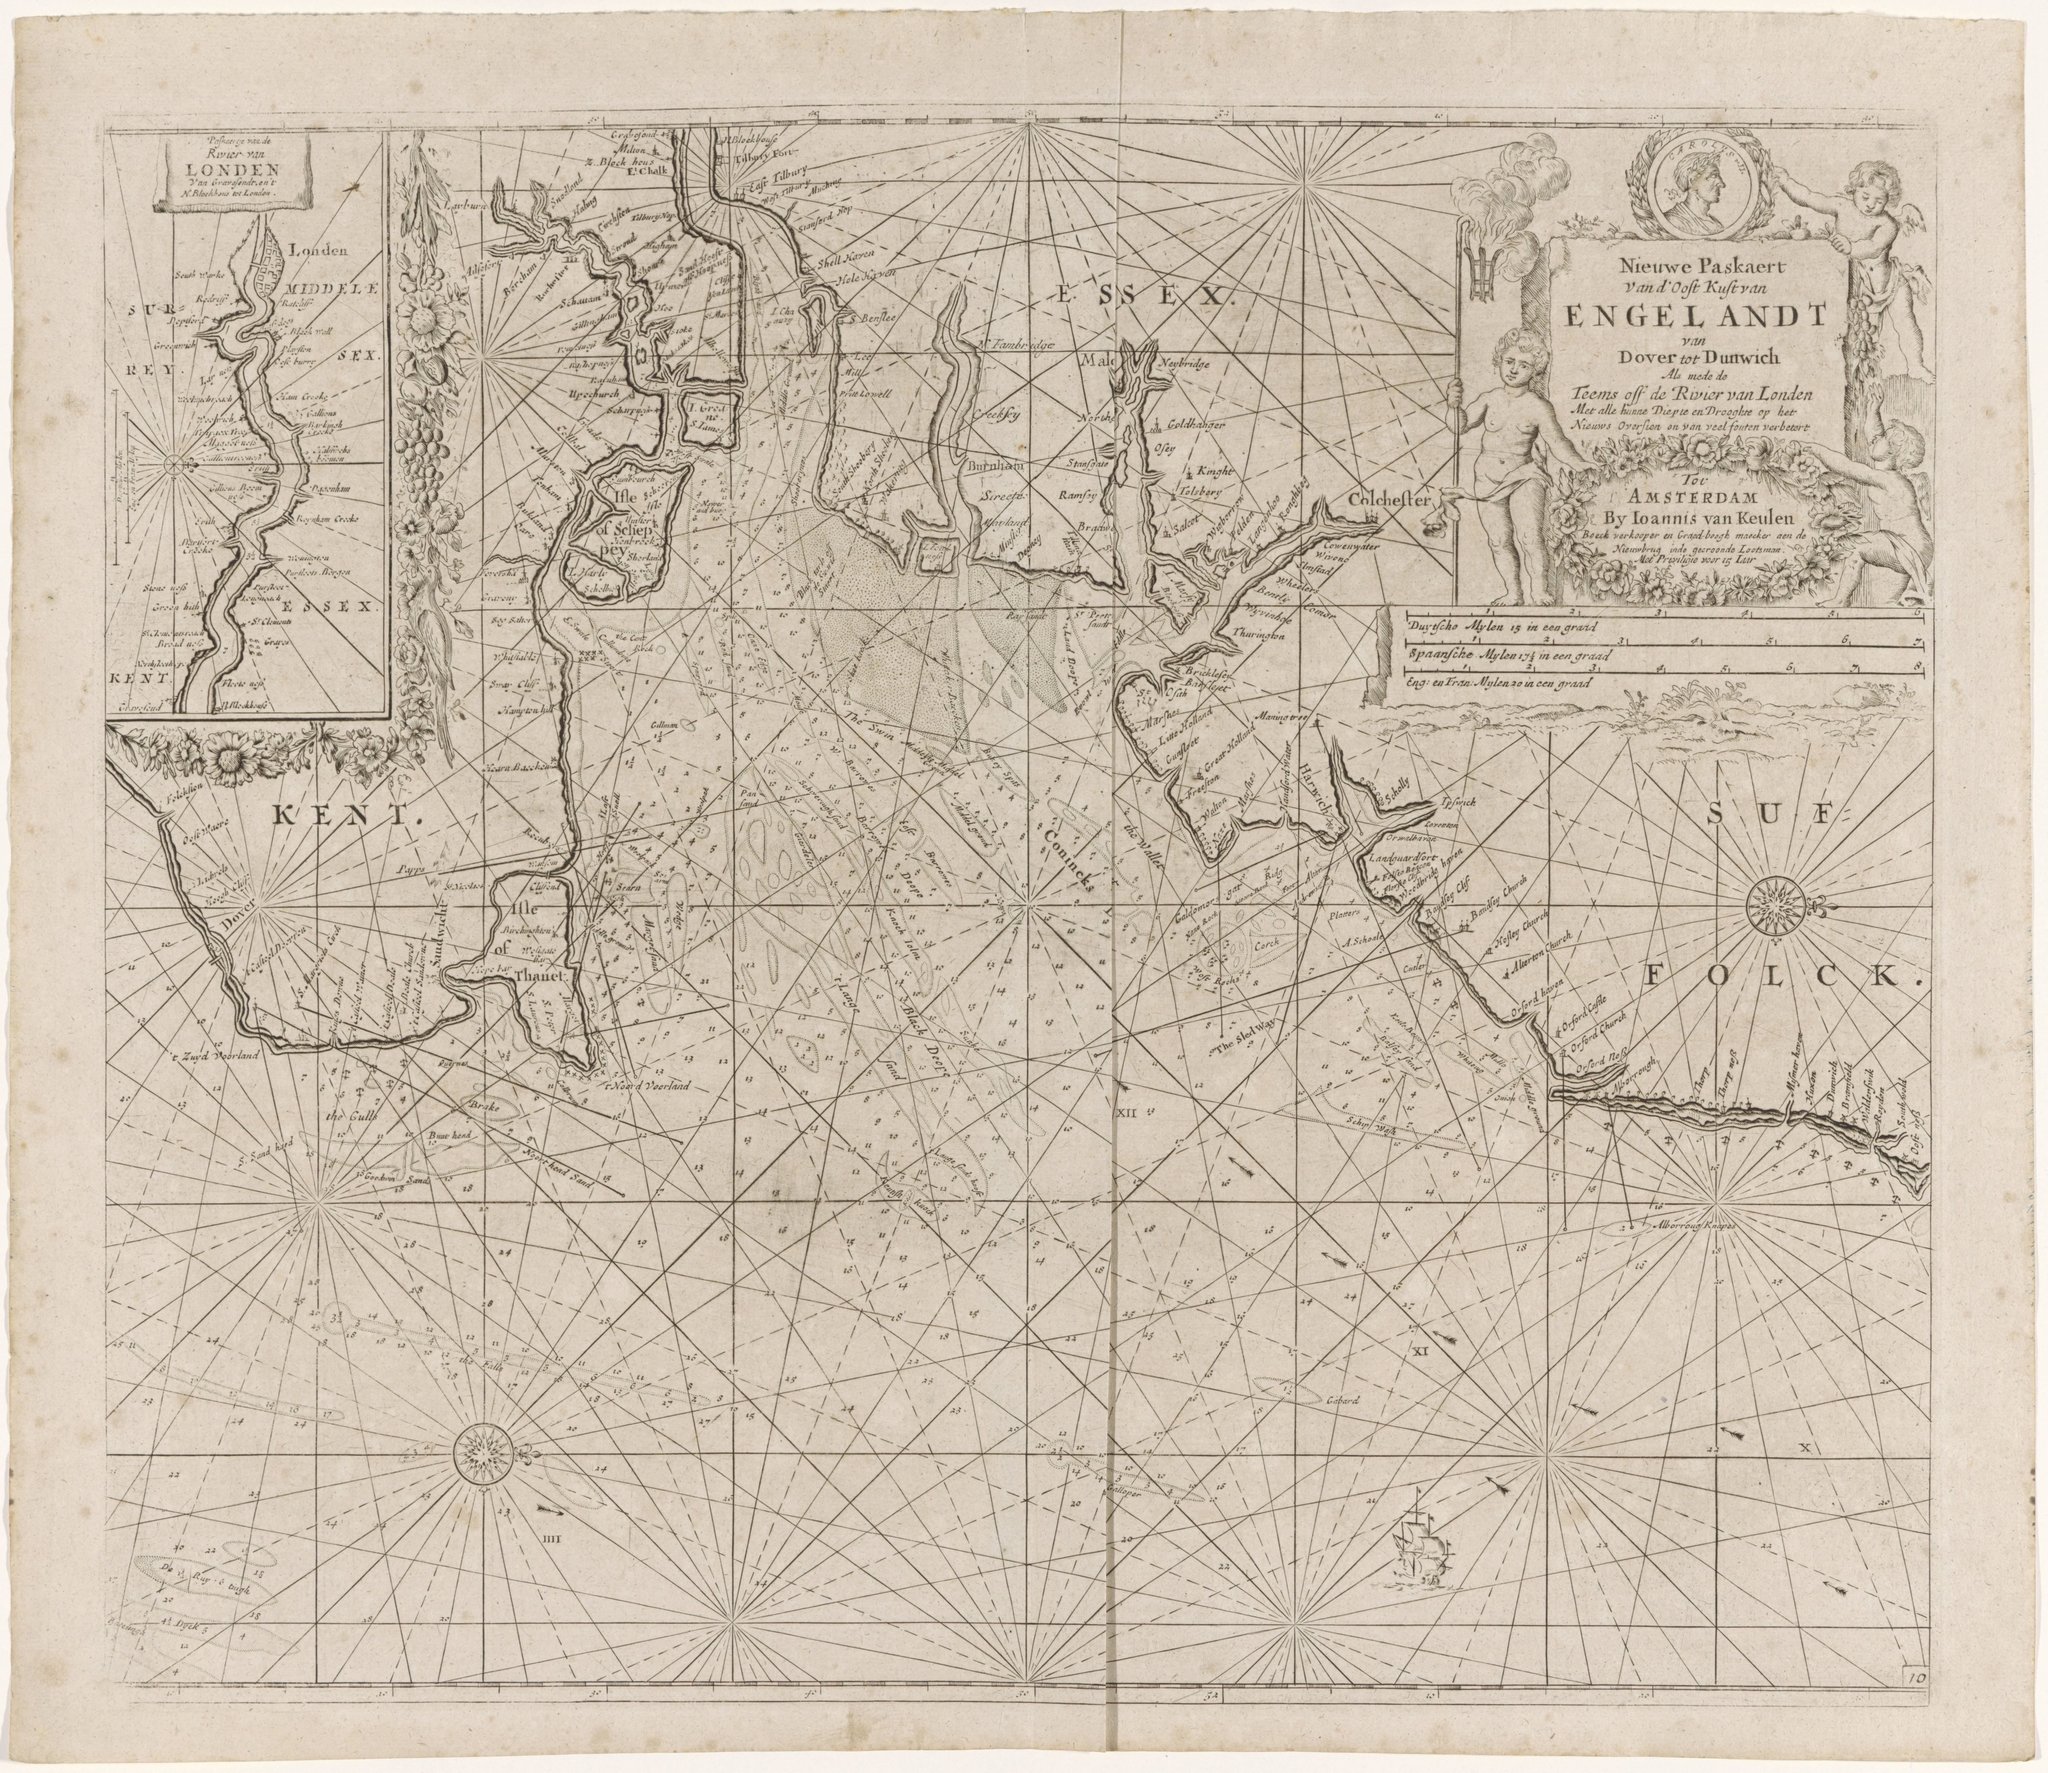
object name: print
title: Nieuwe Paskaert Van d'Oost Kust van Engelandt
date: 1681-1803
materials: paper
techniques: engraving, etching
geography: amsterdam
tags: sailing-ship, sailing-boat, cupids: 'amores', 'amoretti', 'putti', england, thames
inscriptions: collector's mark: Lugt 2228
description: Paskaart van een deel van de oostkust van Engeland met de monding van de Theems en een inzetkaart van de Theems tot Londen, met drie kompasrozen. De omlijsting van de inzetkaart is versierd met bloemen. Rechtsboven een cartouche met de titel, het adres van de uitgever en de schaalverdeling, weergegeven in Duitse, Spaanse en Engelse of Franse mijlen (schaal: c. 1:300.000). Bij deze gegevens staan drie putti, waarvan er een een vuurbaken vast houdt en een ander een medaillion met een portret.